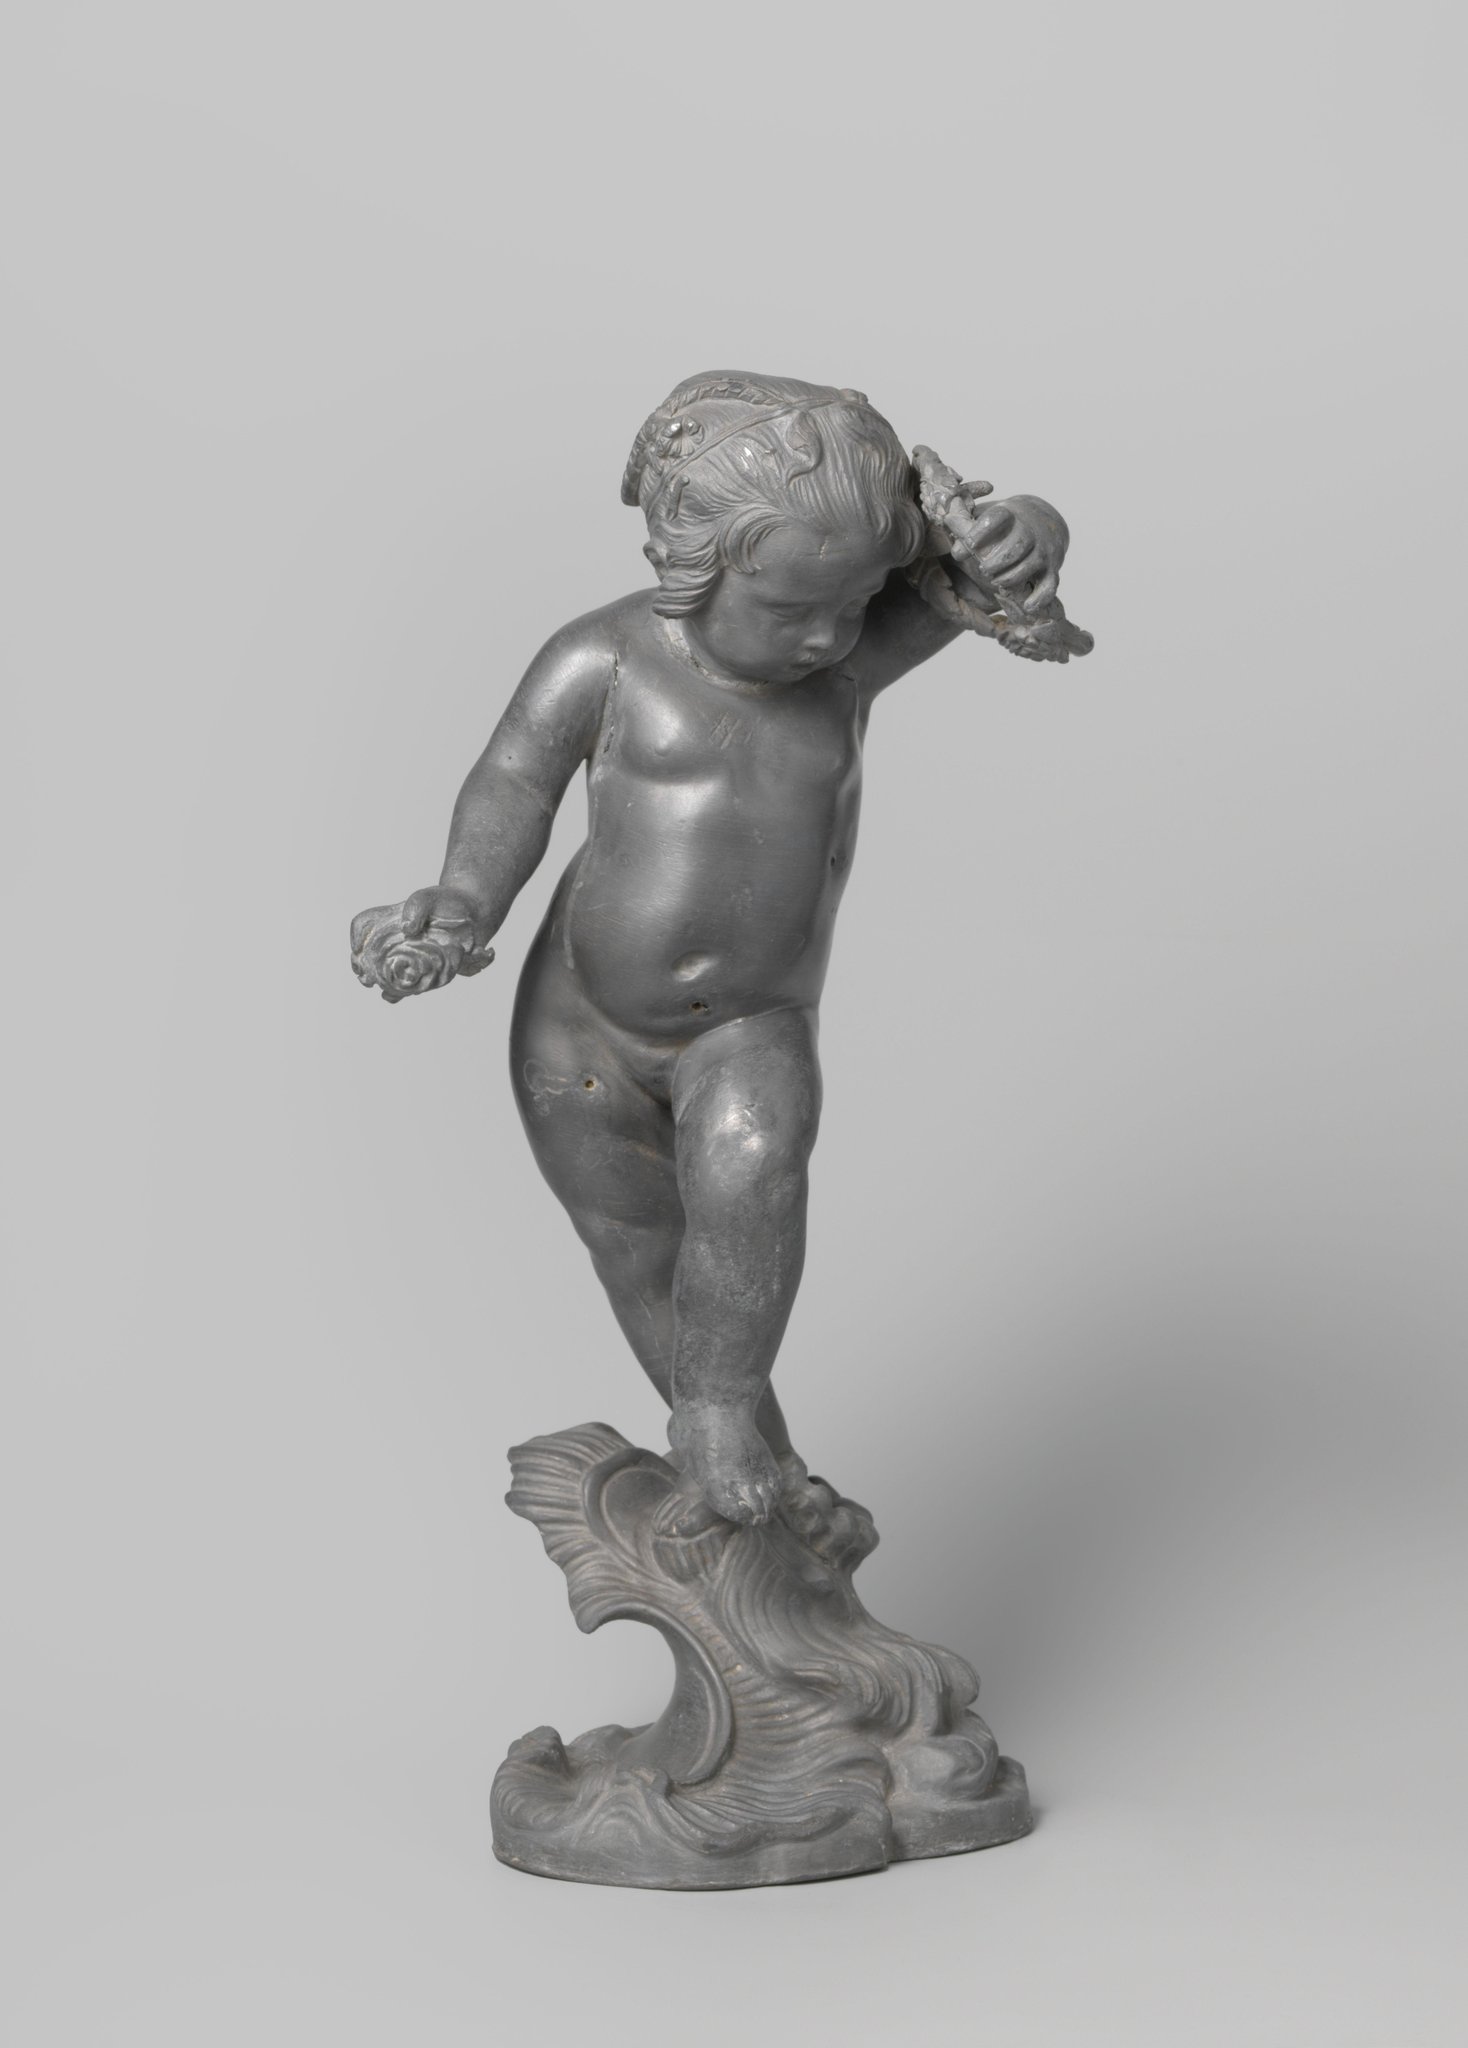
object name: sculpture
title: Allegory of Spring, from a Series of the Four Seasons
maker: willem rottermondt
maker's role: sculptor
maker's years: 1701-1755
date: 1730-1750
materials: lead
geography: northern netherlands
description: Putti, representing the Four Seasons. Lead. Netherlands, c. 1745.